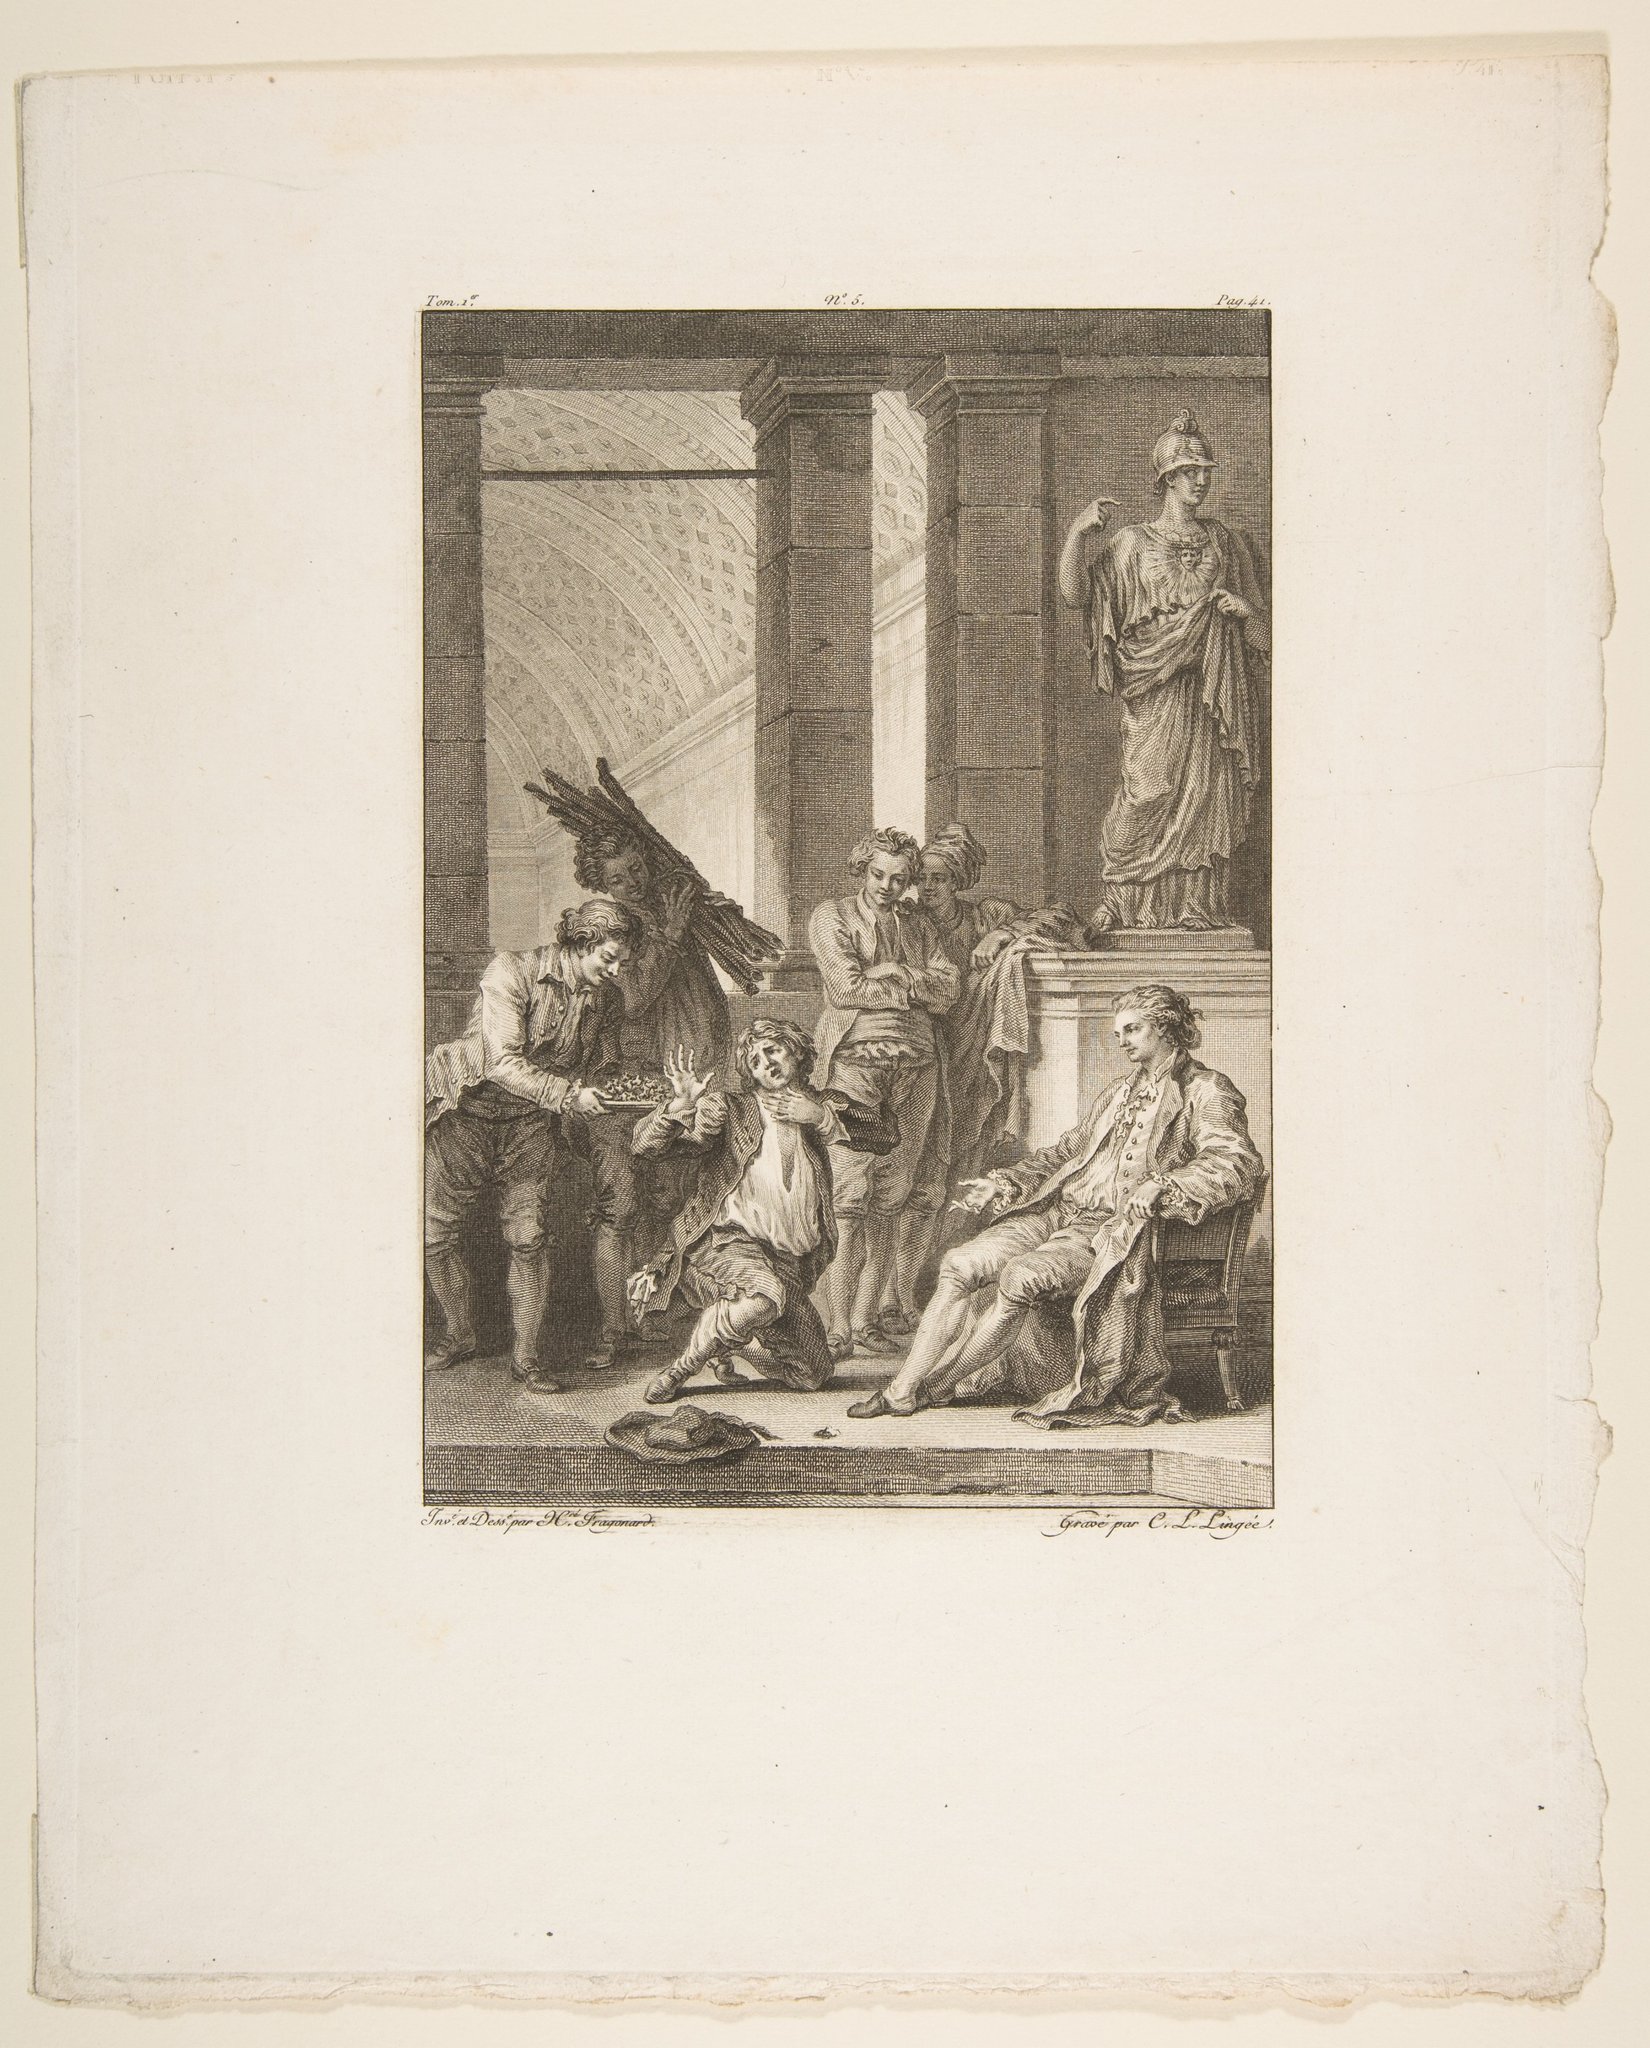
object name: print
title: Le Paysan qui avait offense son Seigneur, from Contes et nouvelles en vers par Jean de La Fontaine. A Paris, de l'imprimerie de P. Didot, l'an III de la République, 1795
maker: charles louis lingée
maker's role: artist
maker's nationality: french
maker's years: 1751-1819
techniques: engraving, etching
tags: human figures